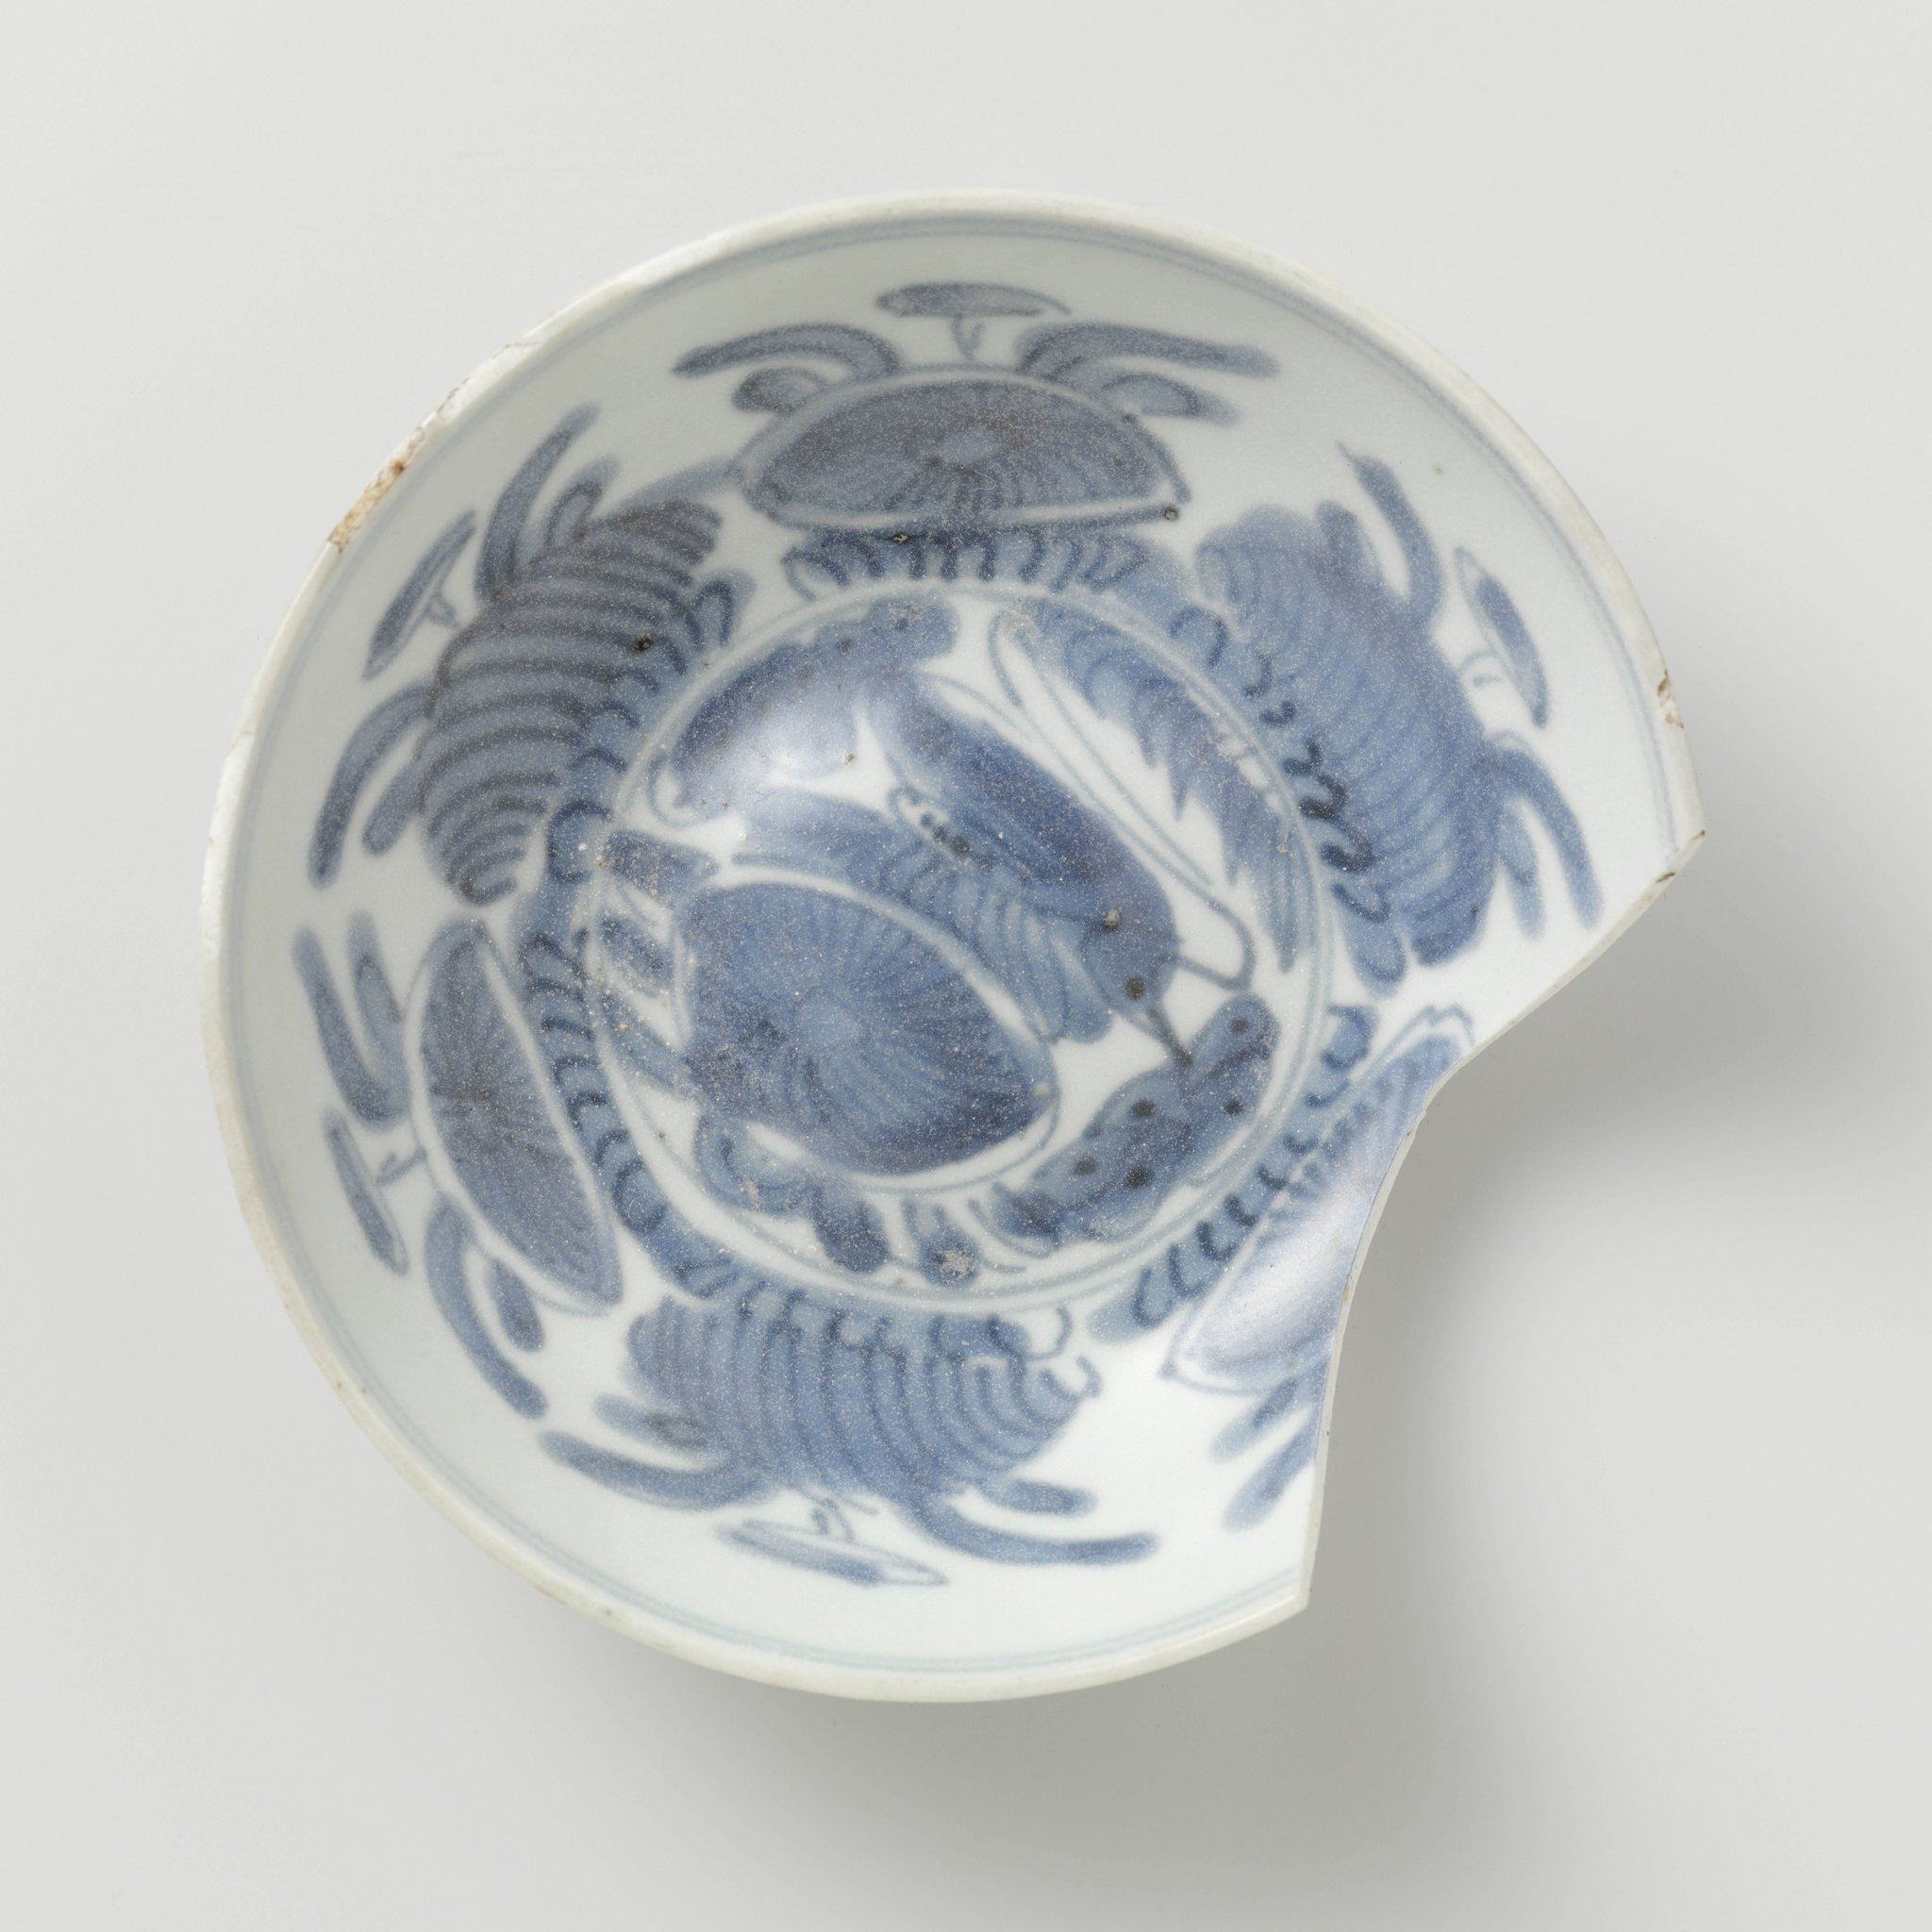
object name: platter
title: Schotel uit V.O.C.-schip de 'Witte Leeuw'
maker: Anonymous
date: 1613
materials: porcelain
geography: jingdezhen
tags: verenigde oostindische compagnie, sint-helena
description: A saucer. The colour of the cobalt blue varies from grey to purple blue. The decoration on the inside consists of a flowering lotus plant with a duck underneath in the centre. On the cavetto 6 similar lotus plants are drawn.